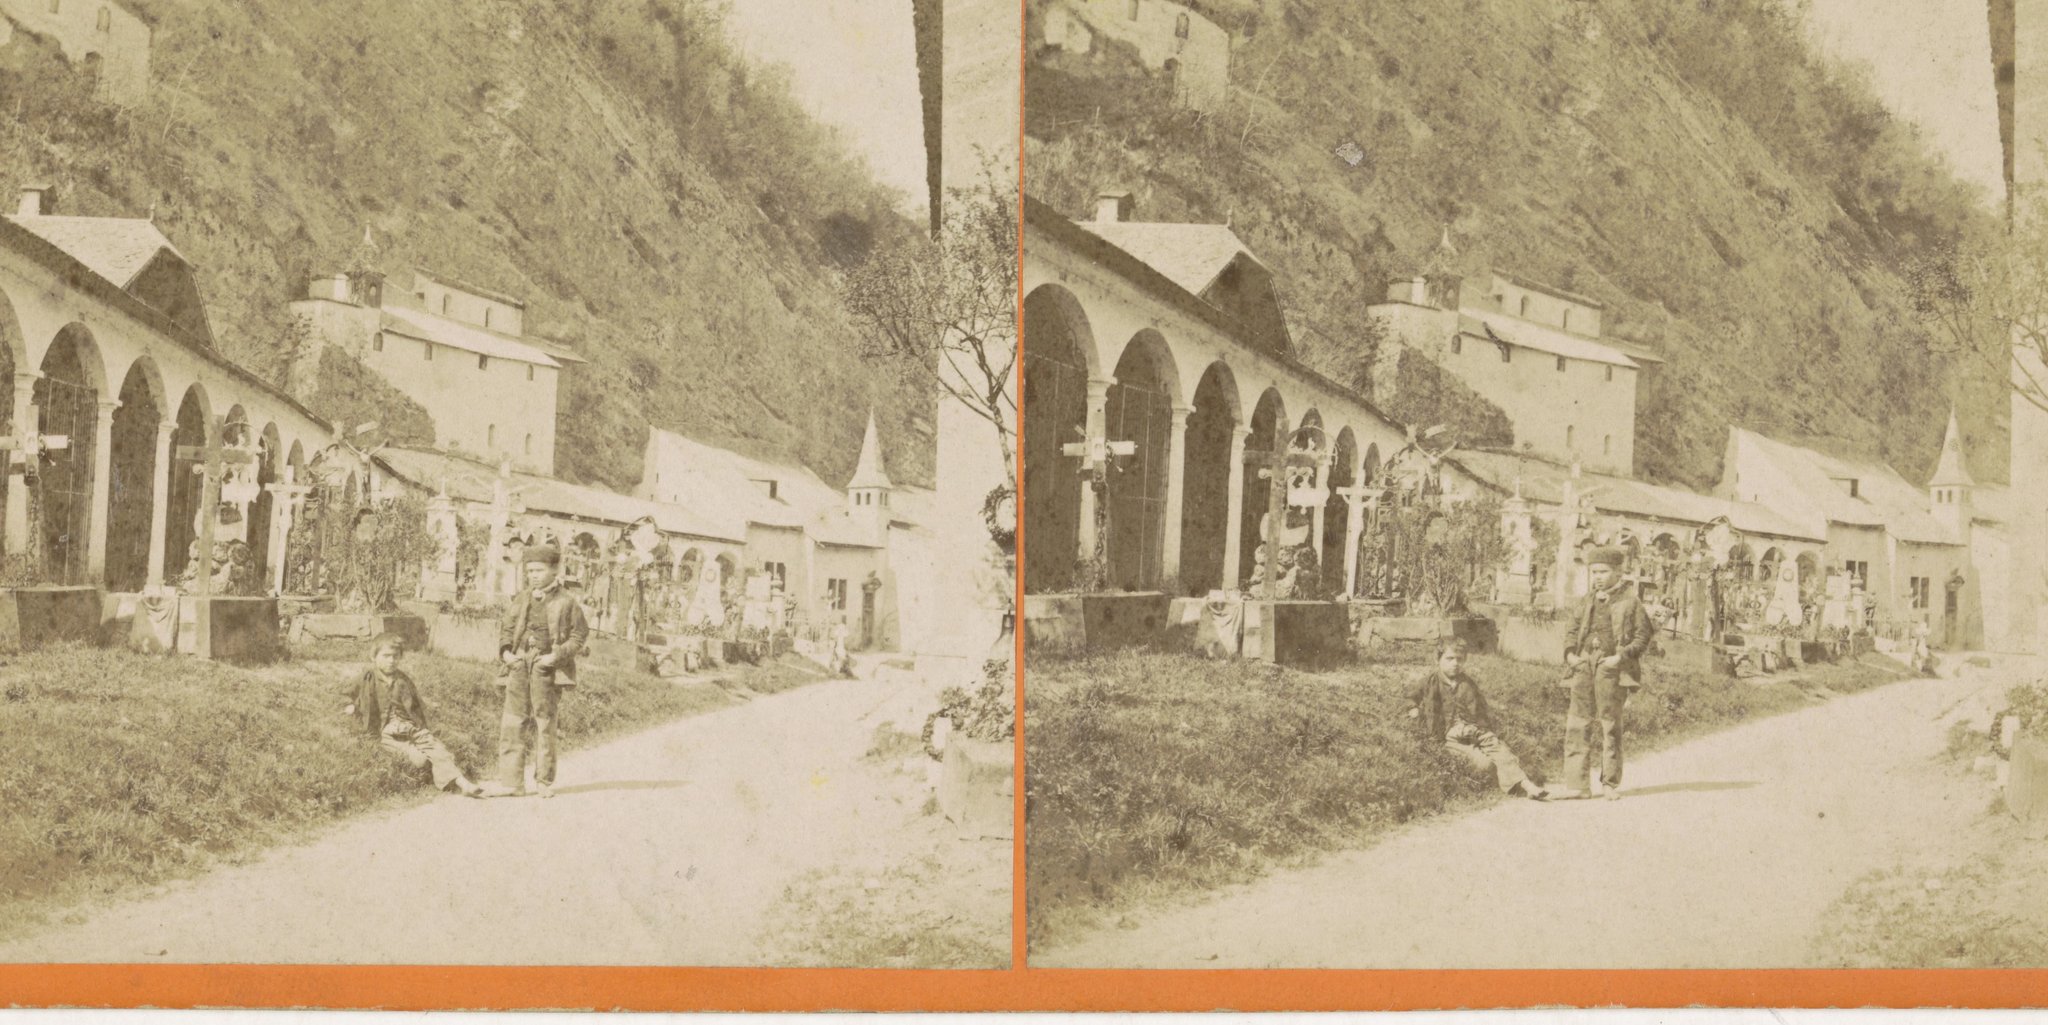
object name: stereograph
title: Twee kinderen op het Petersfriedhof, Salzburg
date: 1862-1880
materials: cardboard, paper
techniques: albumen print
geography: salzburg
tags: churchyard, cemetery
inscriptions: number: ‘No. 4’